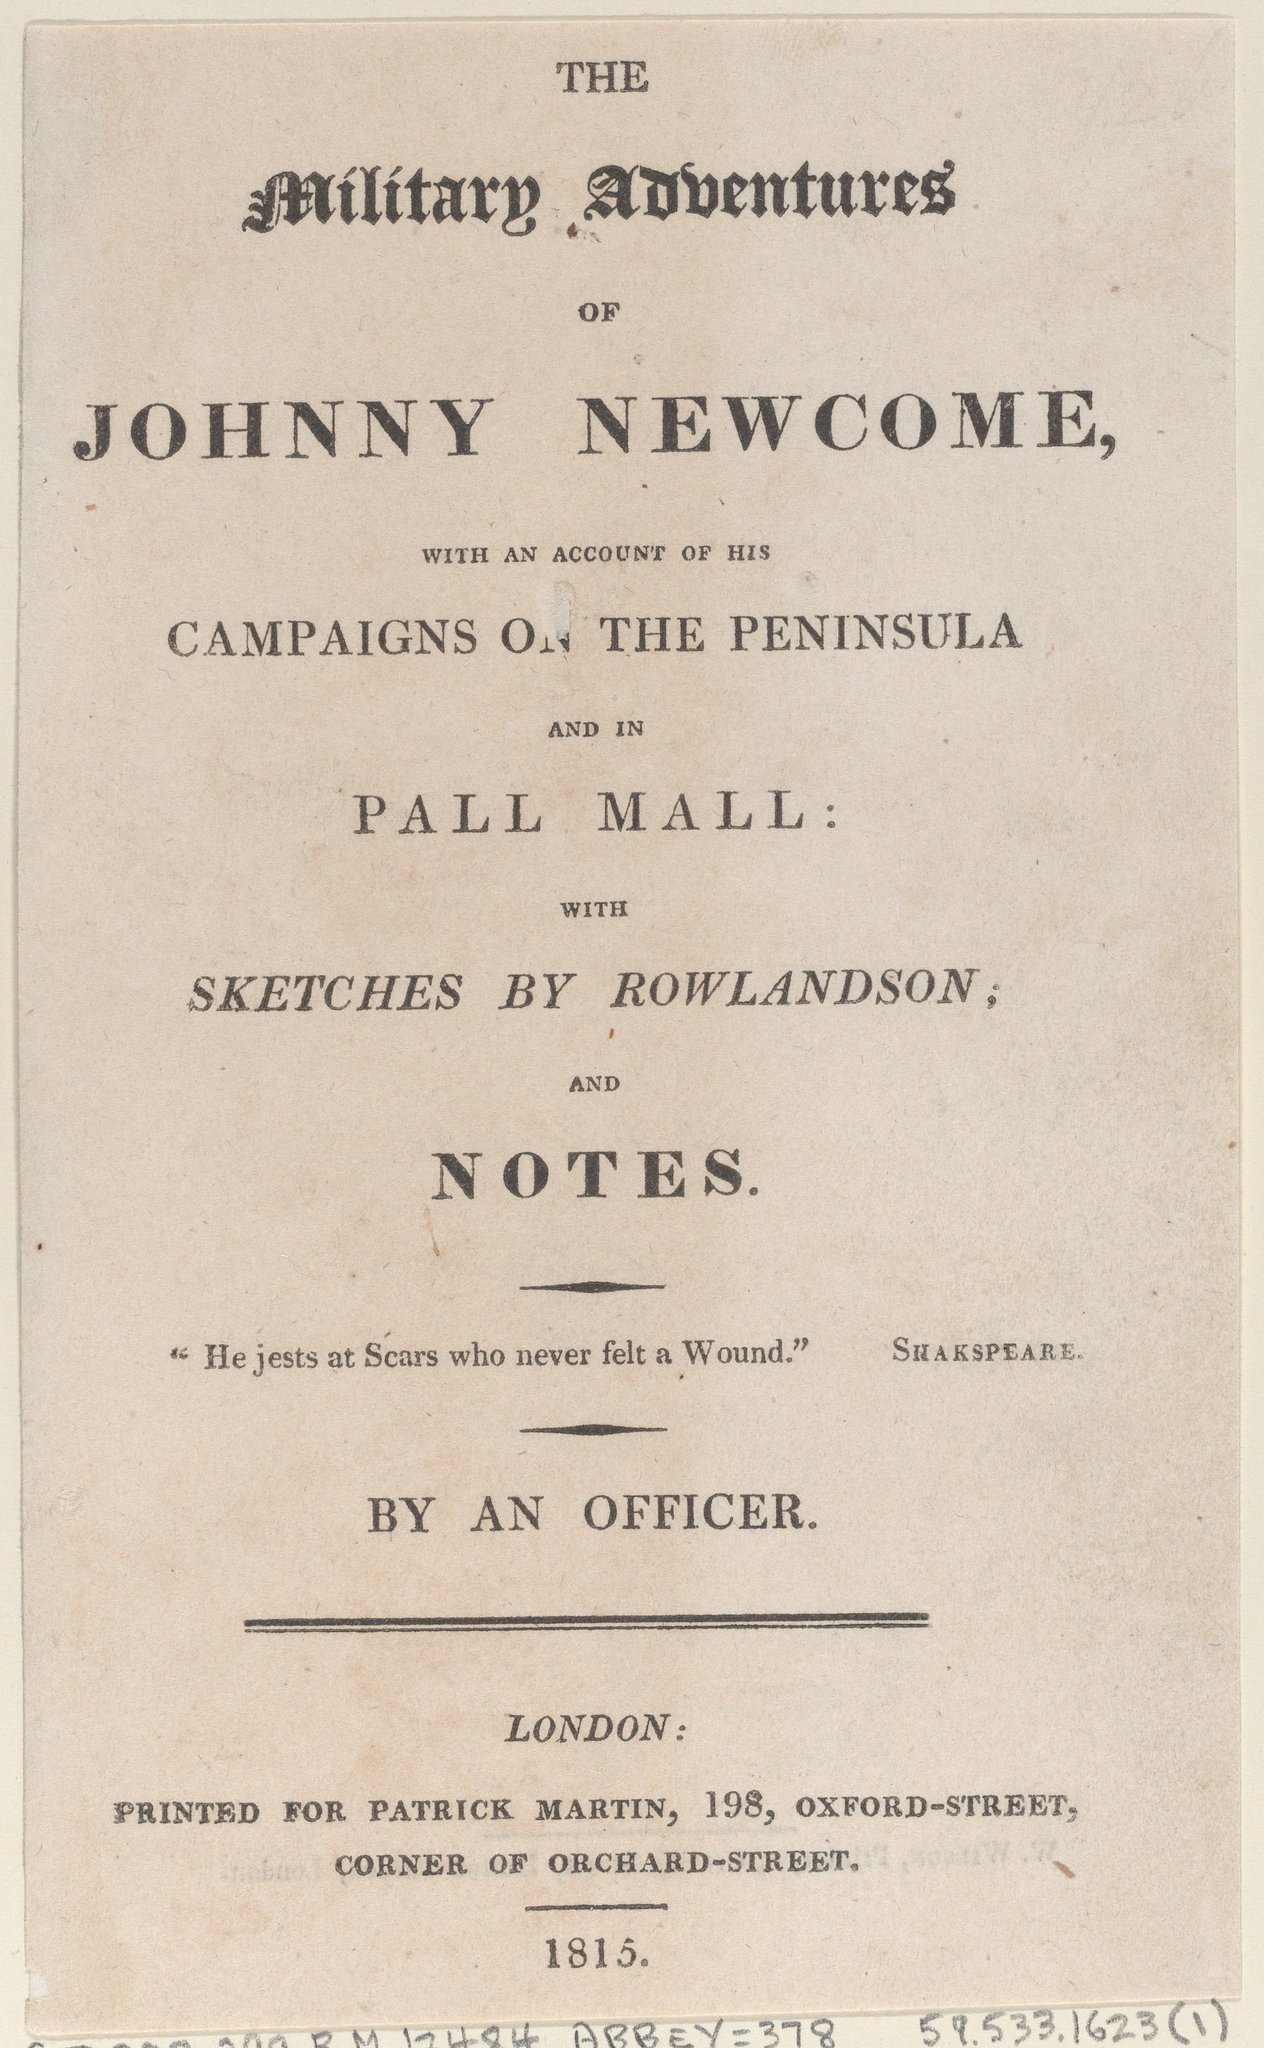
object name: print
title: Title page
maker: thomas rowlandson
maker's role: artist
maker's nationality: british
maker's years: 1757-1827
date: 1815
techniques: letterpress